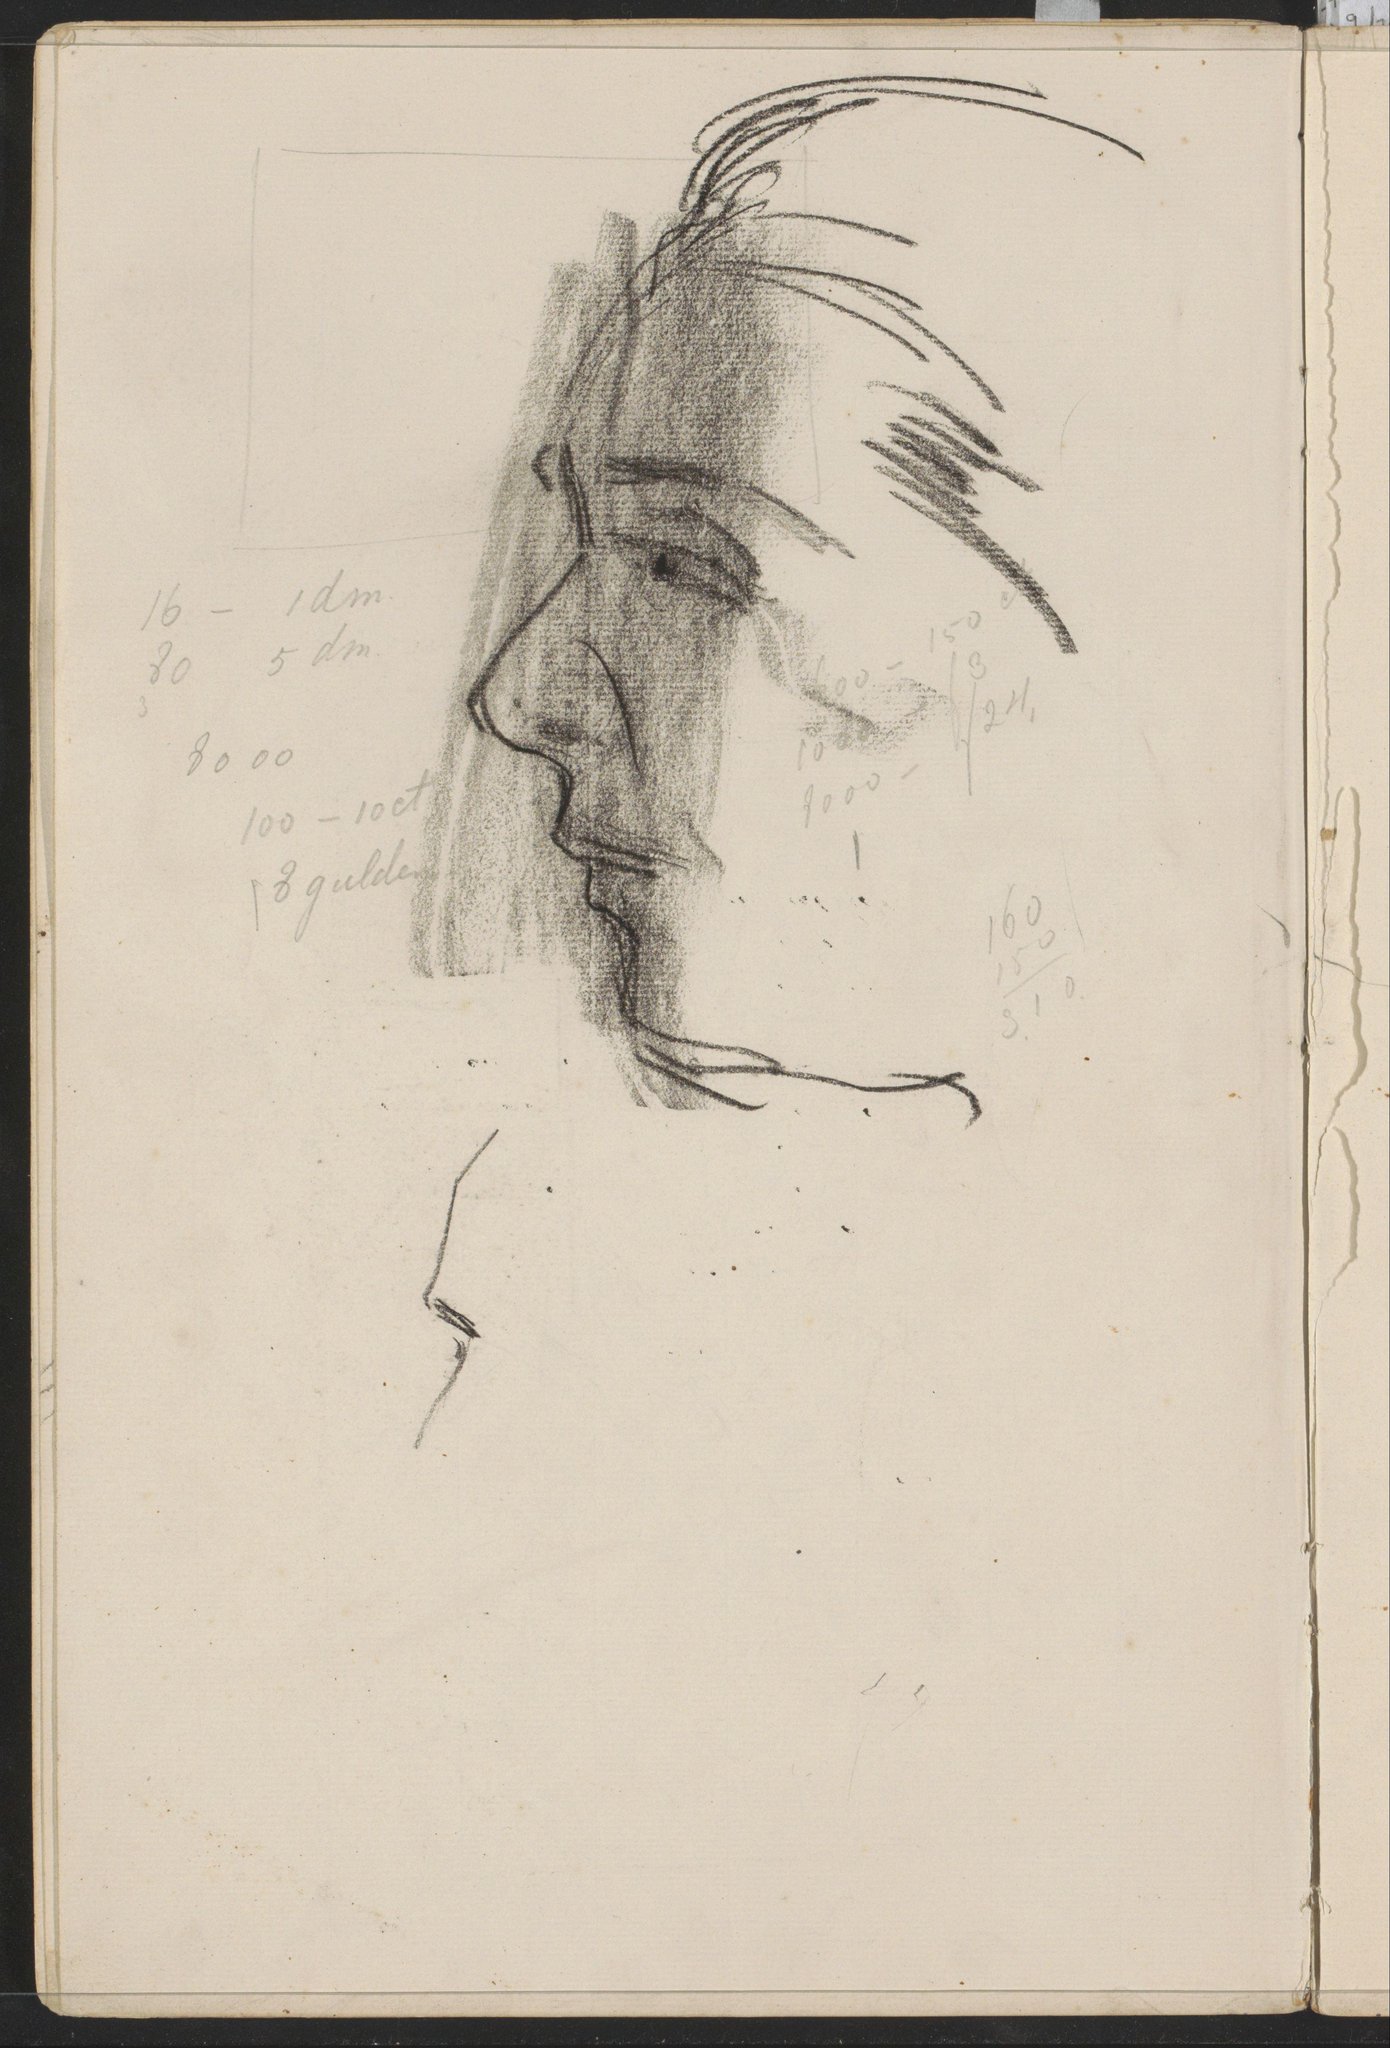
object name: sketchbook leaf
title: Kop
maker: carel adolph lion cachet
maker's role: draughtsman, print maker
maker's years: 1864-1945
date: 1897-1898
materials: chalk, paper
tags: head (human)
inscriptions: annotation: ‘[...]’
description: Blad 8 verso uit een schetsboek met 29 bladen.